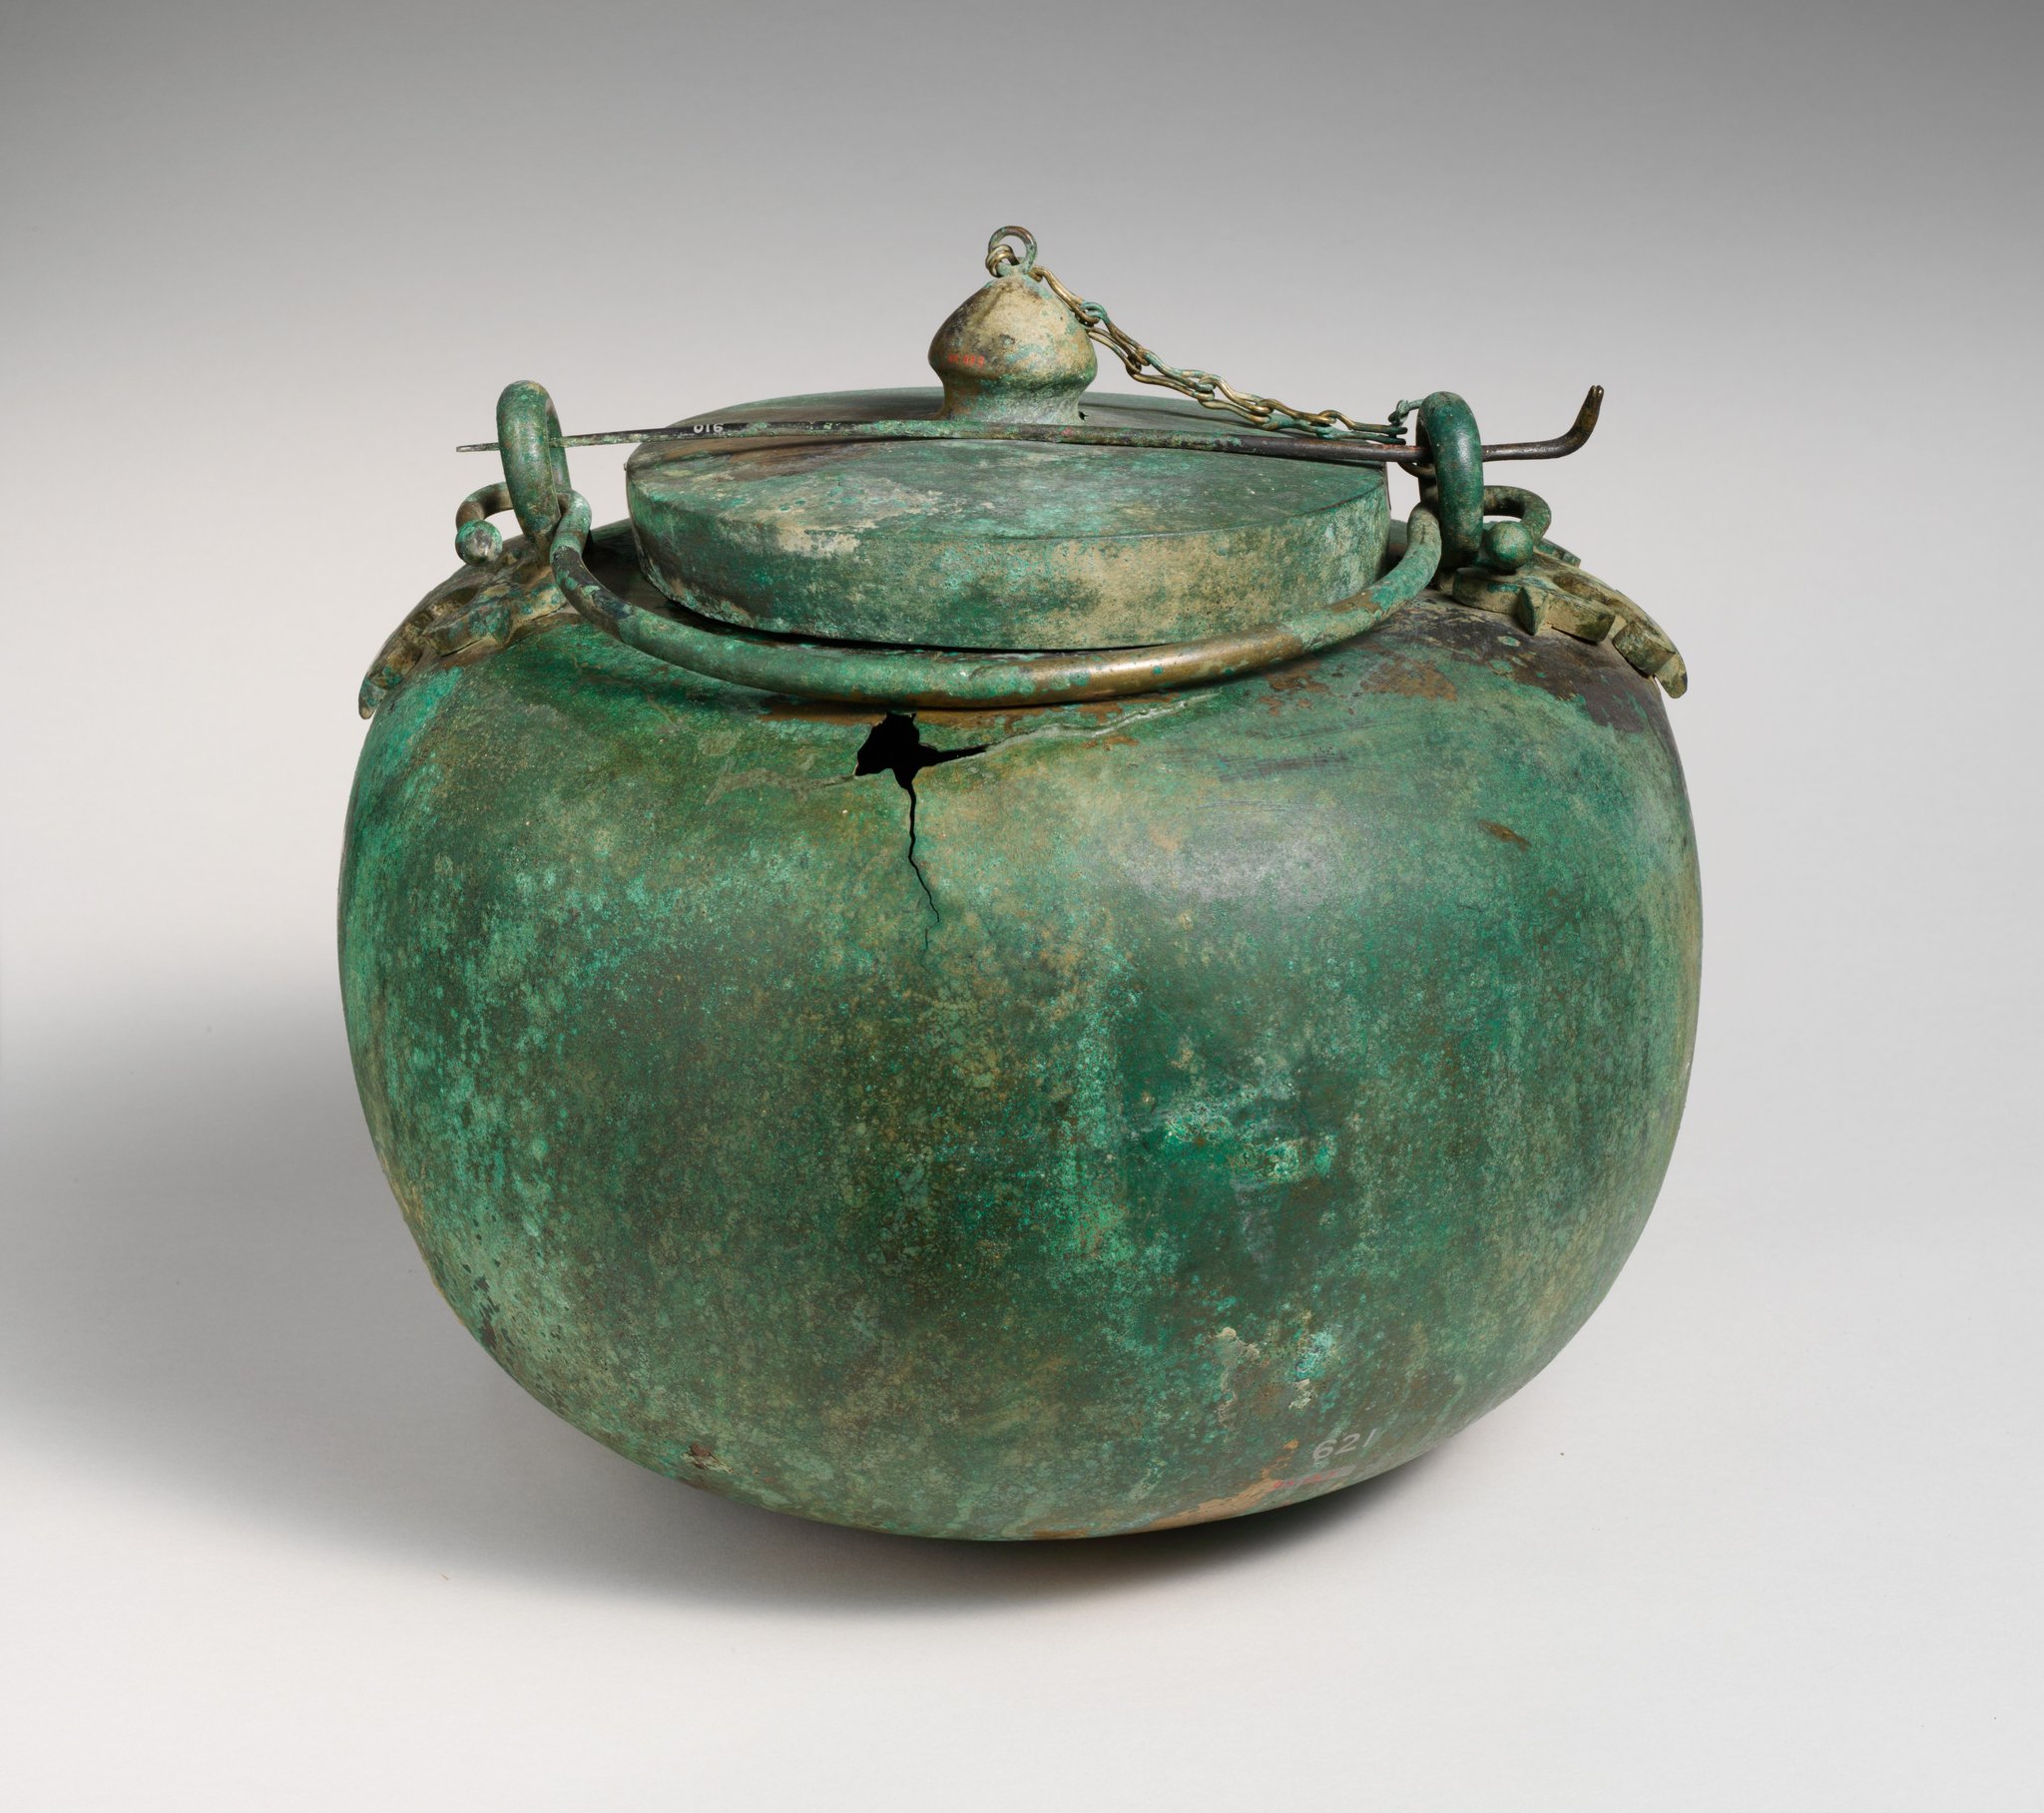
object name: pin with snake head terminal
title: Bronze pin with snake-head terminal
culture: etruscan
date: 550 BCE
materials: bronze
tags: snakes